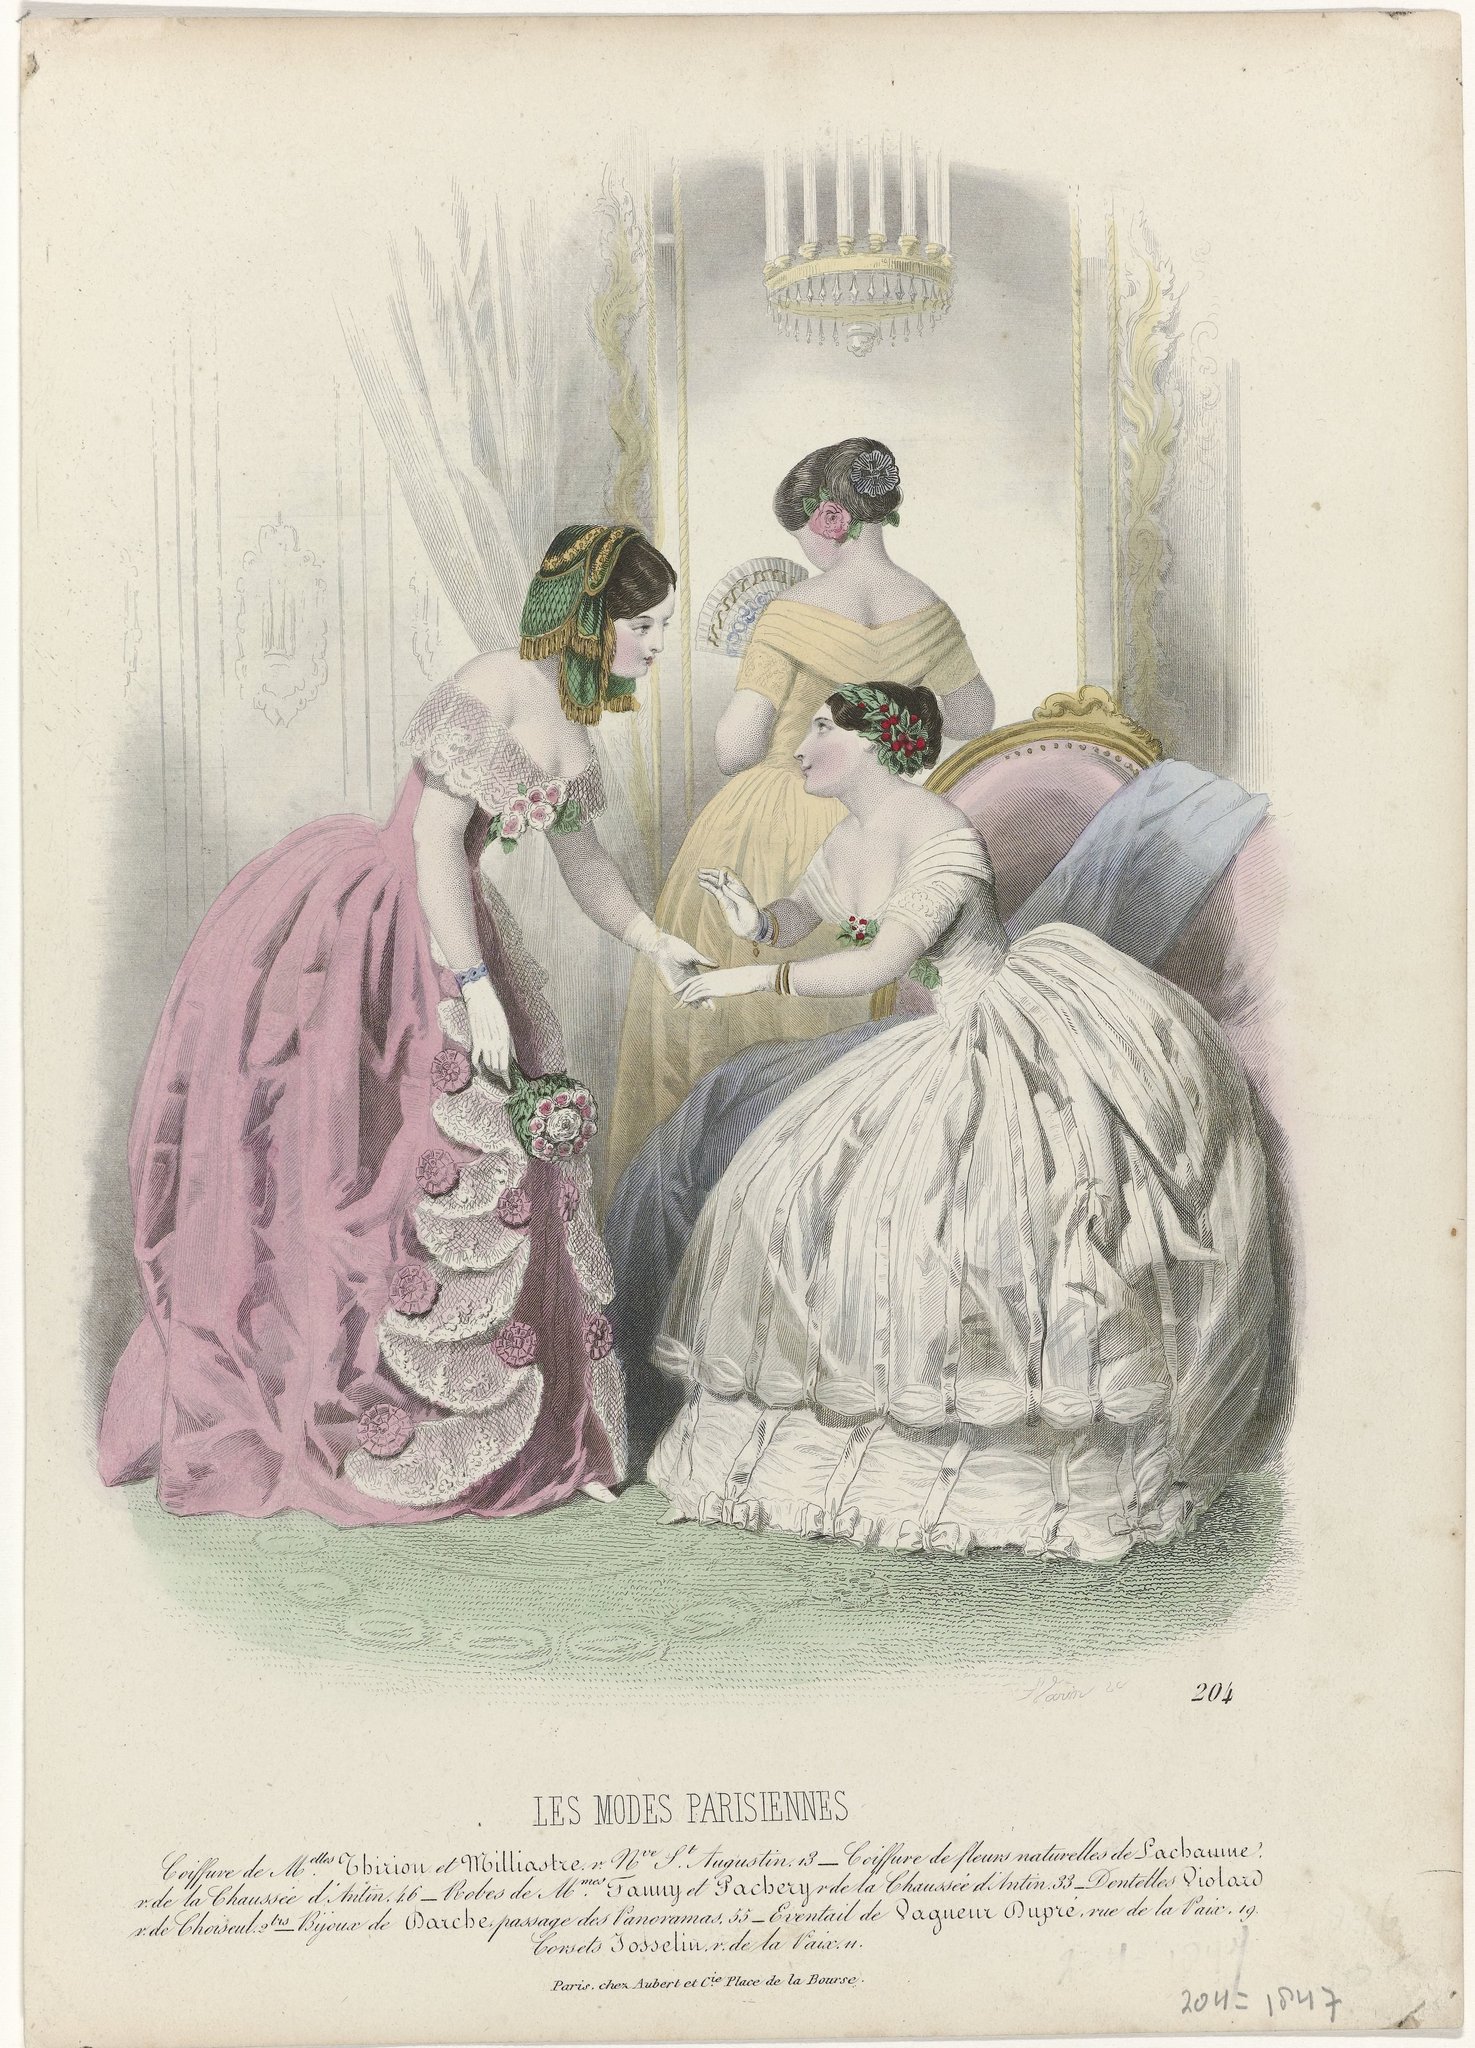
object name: fashion print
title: Les Modes Parisiennes, 24 janvier 1847, No. 204 : Coiffure de Melles Thirion (...)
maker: varin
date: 1847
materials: paper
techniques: engraving, hand coloring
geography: paris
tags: corsage (+ women's clothes), cut flowers; nosegay, bunch of flowers, dress, gown: evening dress (+ women's clothes), lace (+ women's clothes), gloves, mittens (short gloves) (+ women's clothes), neck-gear ~ clothing (bertha) (+ women's clothes), styles of hairdress - aa - ~ women, fashion plates, gloves, mittens, etc. (+ women's clothes), fan (+ women's clothes), bracelet, wristlet (+ women's clothes)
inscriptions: address: ‘Paris chez Aubert et C.ie Place de la Bourse.’, title: ‘Les Modes Parisiennes.’, caption: ‘Coiffure de M.elles Thirion et Milliastre, r. Nve S.t Augustin, 13 _ Coiffure de fleurs naturelles de Lachaume r. de la Chaussée d'Antin, 46 _ Robes de M.mes Fanny et Pachery r de la Chaussée d'Antin, 33 _ Dentelles Violard r. de Choiseul, 2 bis _ Bijoux de Darche, passage des Panoramas, 55 _ Eventail de Vagueur Dupré, rue de la Paix, 19. Corsets Josselin, r. de la Vaix, 11.’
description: Drie vrouwen, van wie één op de rug gezien, in avondkleding. Links: 'coiffure en velours' gegarneerd met een haarnet afgezet met goudkleurige 'aiguillettes', van Thirion en Milliastre. Japon van 'taffetas d'Italie'(tafzijde) gegarneerd met kant en 'choux' (rozetten) van lint. Rechts: 'Coiffure' met bloemen en hulstbladeren, van Lachaume. Japon van tule met gedrapeerd lijfje en twee rokken versierd met linten. Volgens het onderschrift: japonnen van Fanny en Pachery. Kant van Violard. Sieraden van Darche. Waaier van Vagueur Dupré. Hieronder een regel reclametekst voor korsetten van Josselin. Uitgebreide beschrijving van de kleding op pagina 1275 "Détails du Dessin." Prent uit het modetijdschrift Les Modes Parisiennes (1843-1885).